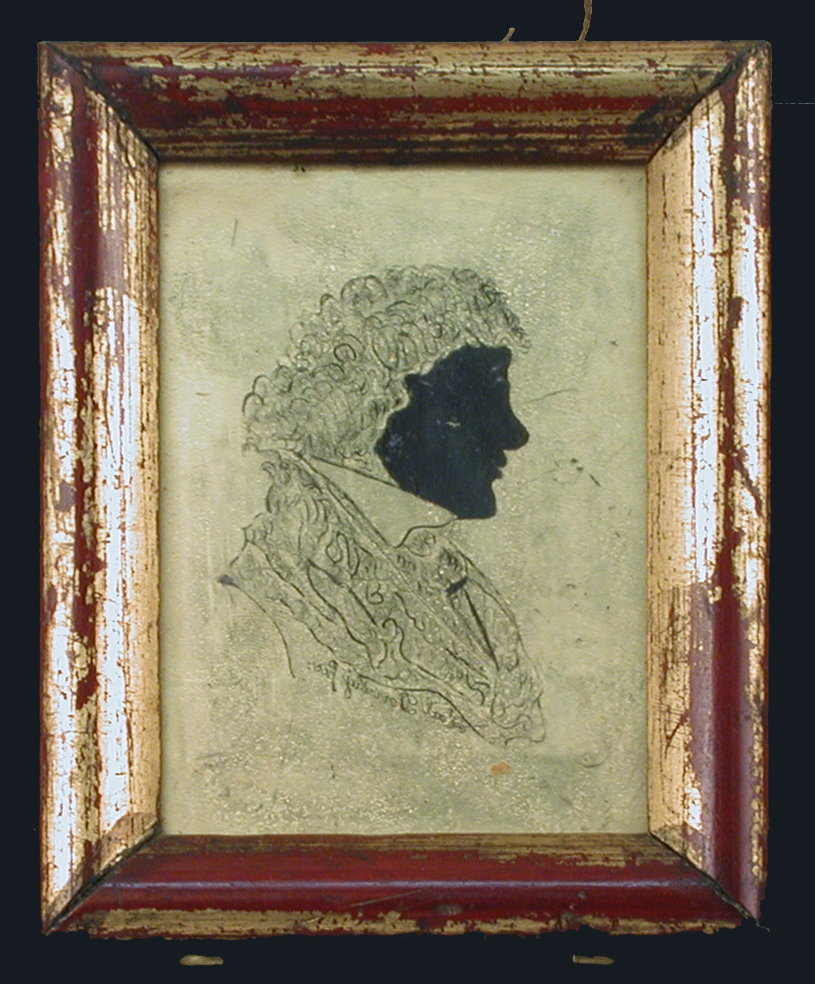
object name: panel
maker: karl domeskijfer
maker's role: artist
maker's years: 1800-1900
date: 1801-1900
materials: glass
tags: men,profiles